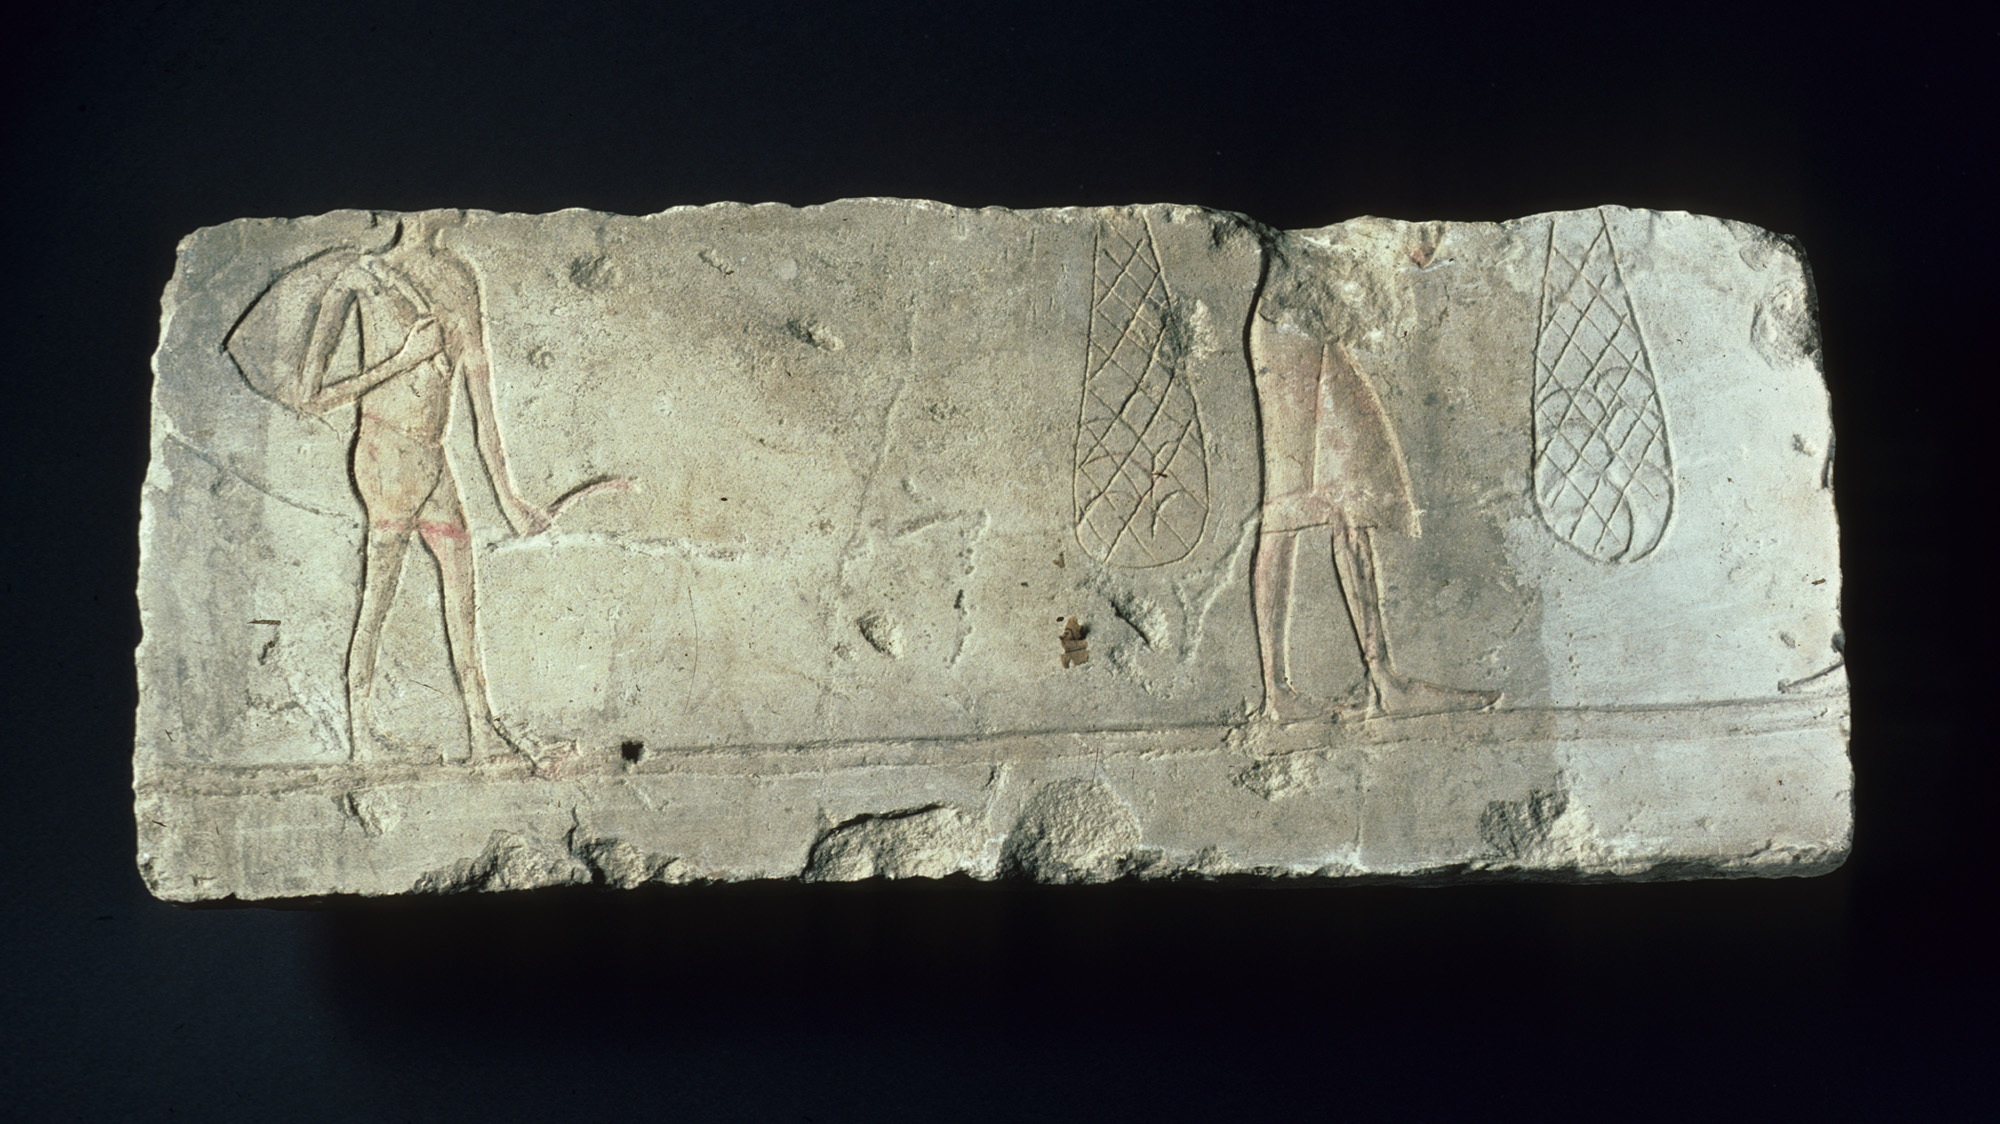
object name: talatat, two laborer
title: Relief with two laborers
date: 1353-1336 BCE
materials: limestone, paint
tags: men